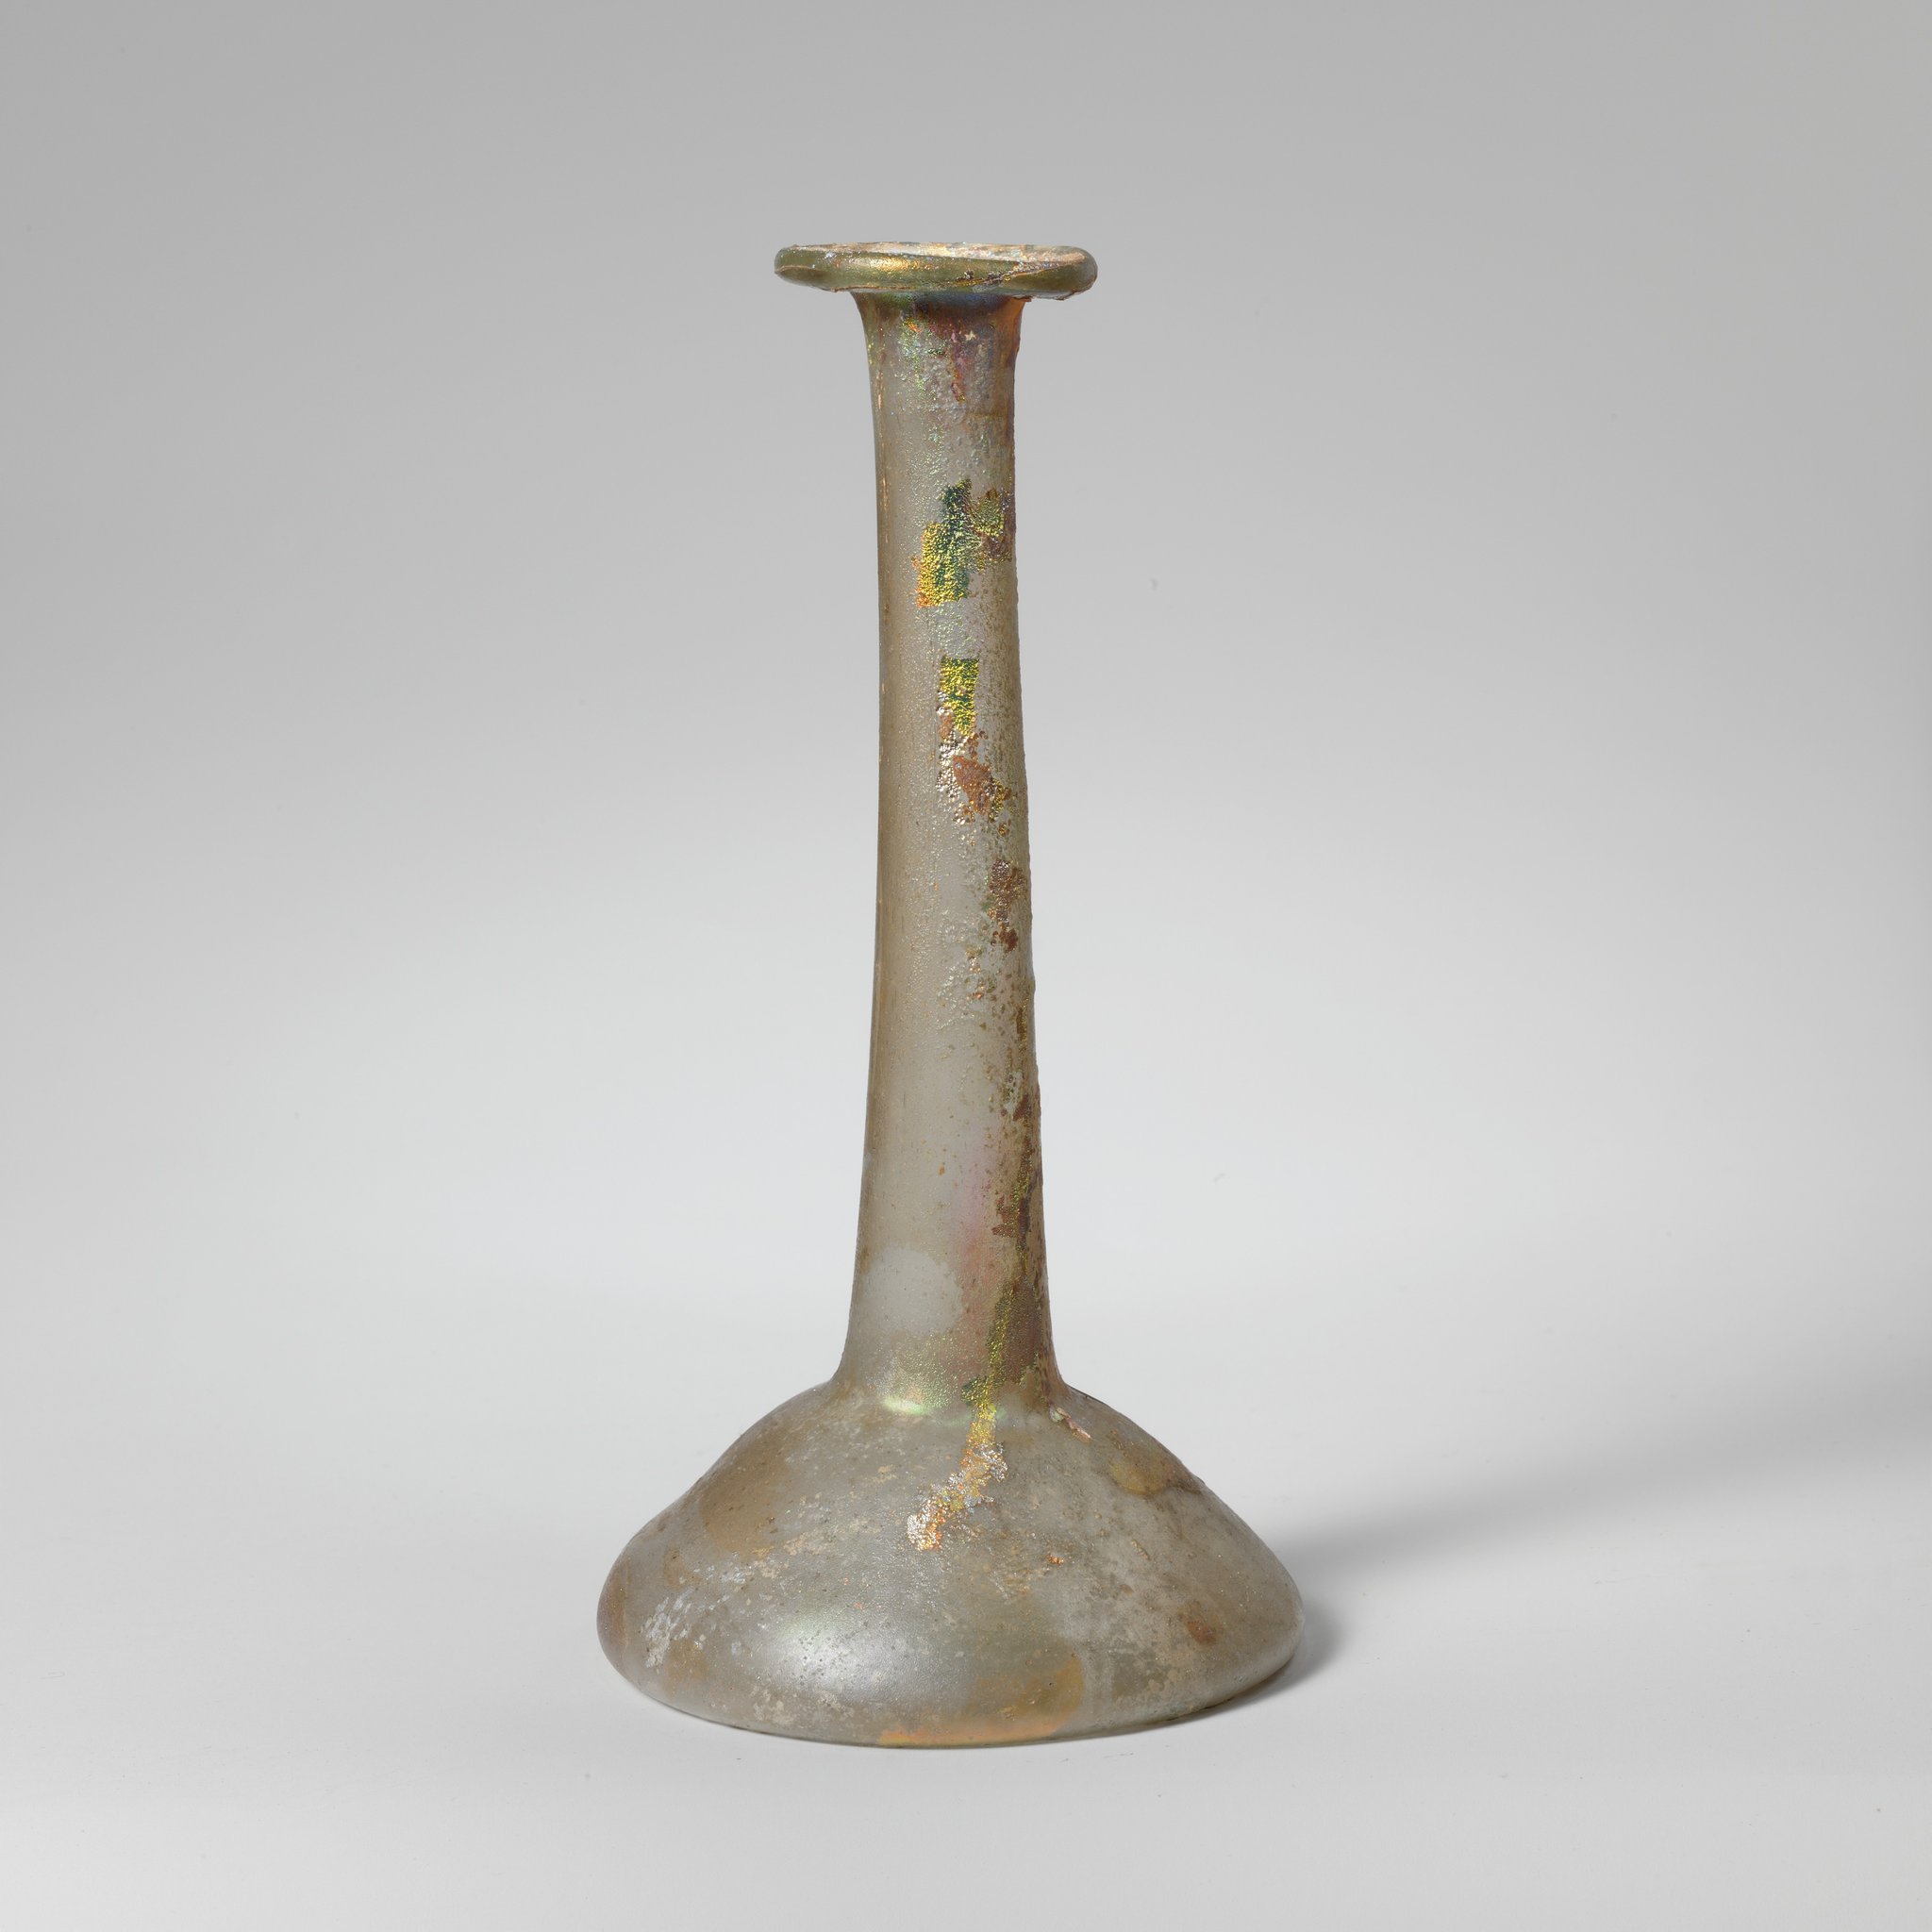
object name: perfume bottle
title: Glass perfume bottle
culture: roman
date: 101-300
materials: glass